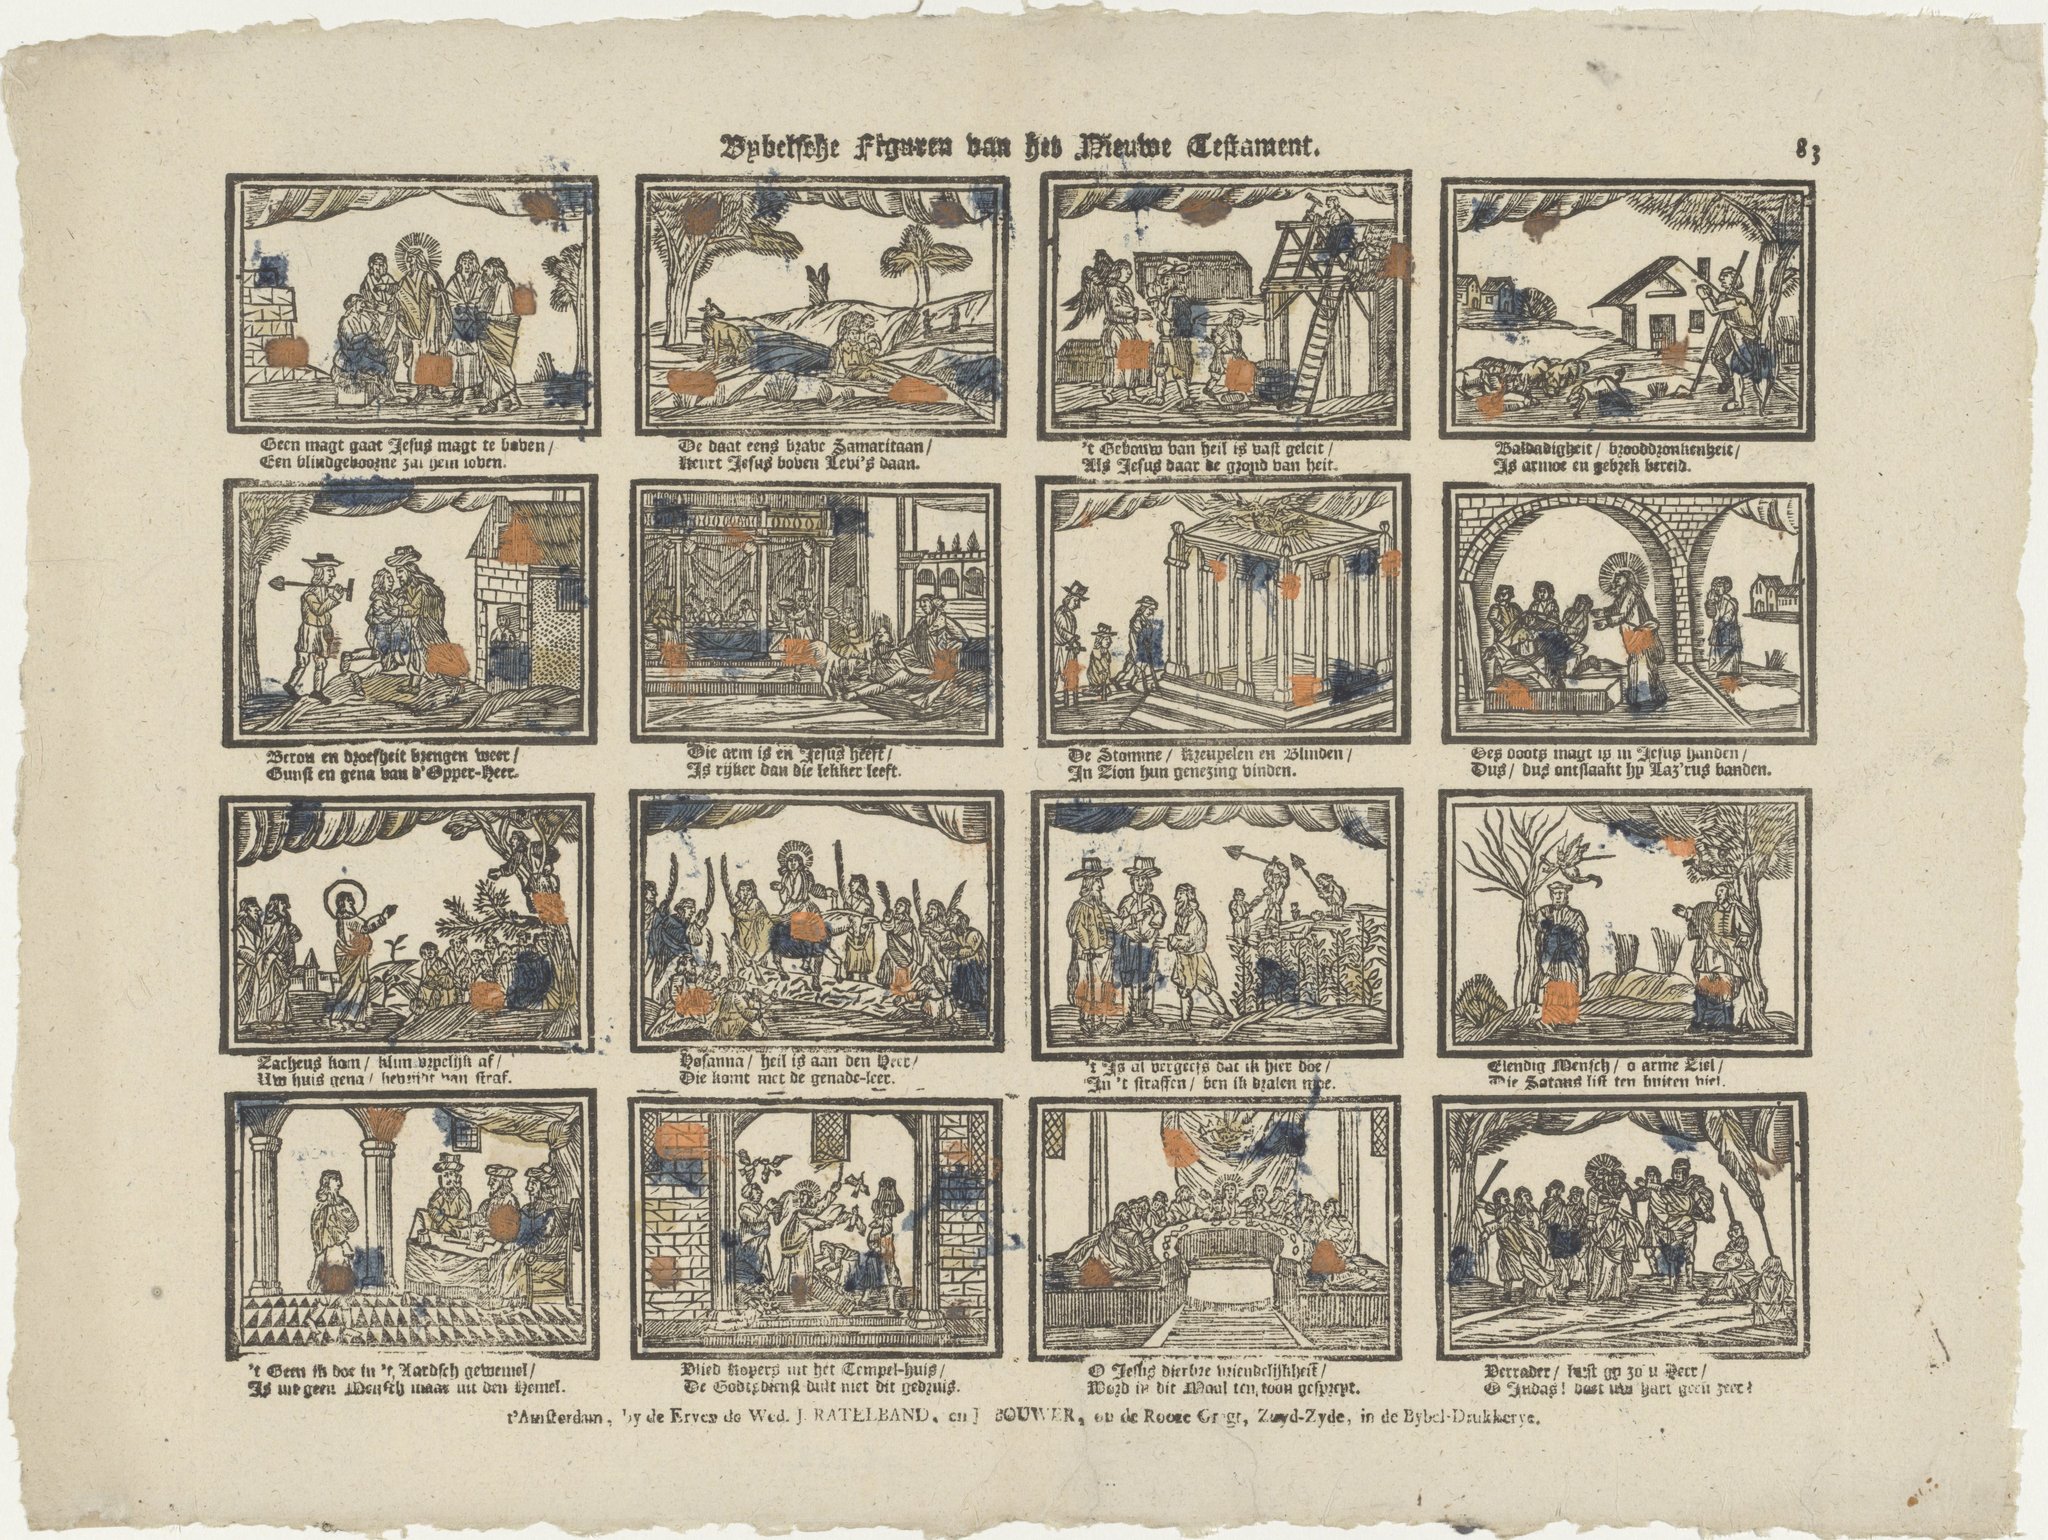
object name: print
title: Bijbelsche figuren van het Nieuwe Testament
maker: Anonymous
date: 1782-1793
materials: paper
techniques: colour, letterpress printing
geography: netherlands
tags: new testament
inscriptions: collector's mark: Lugt 2228, collector's mark: Lugt 2760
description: Blad met 16 voorstellingen van verhalen uit het Nieuwe Testament. Onder elke afbeelding een tweeregelig vers. Genummerd rechtsboven: 83.